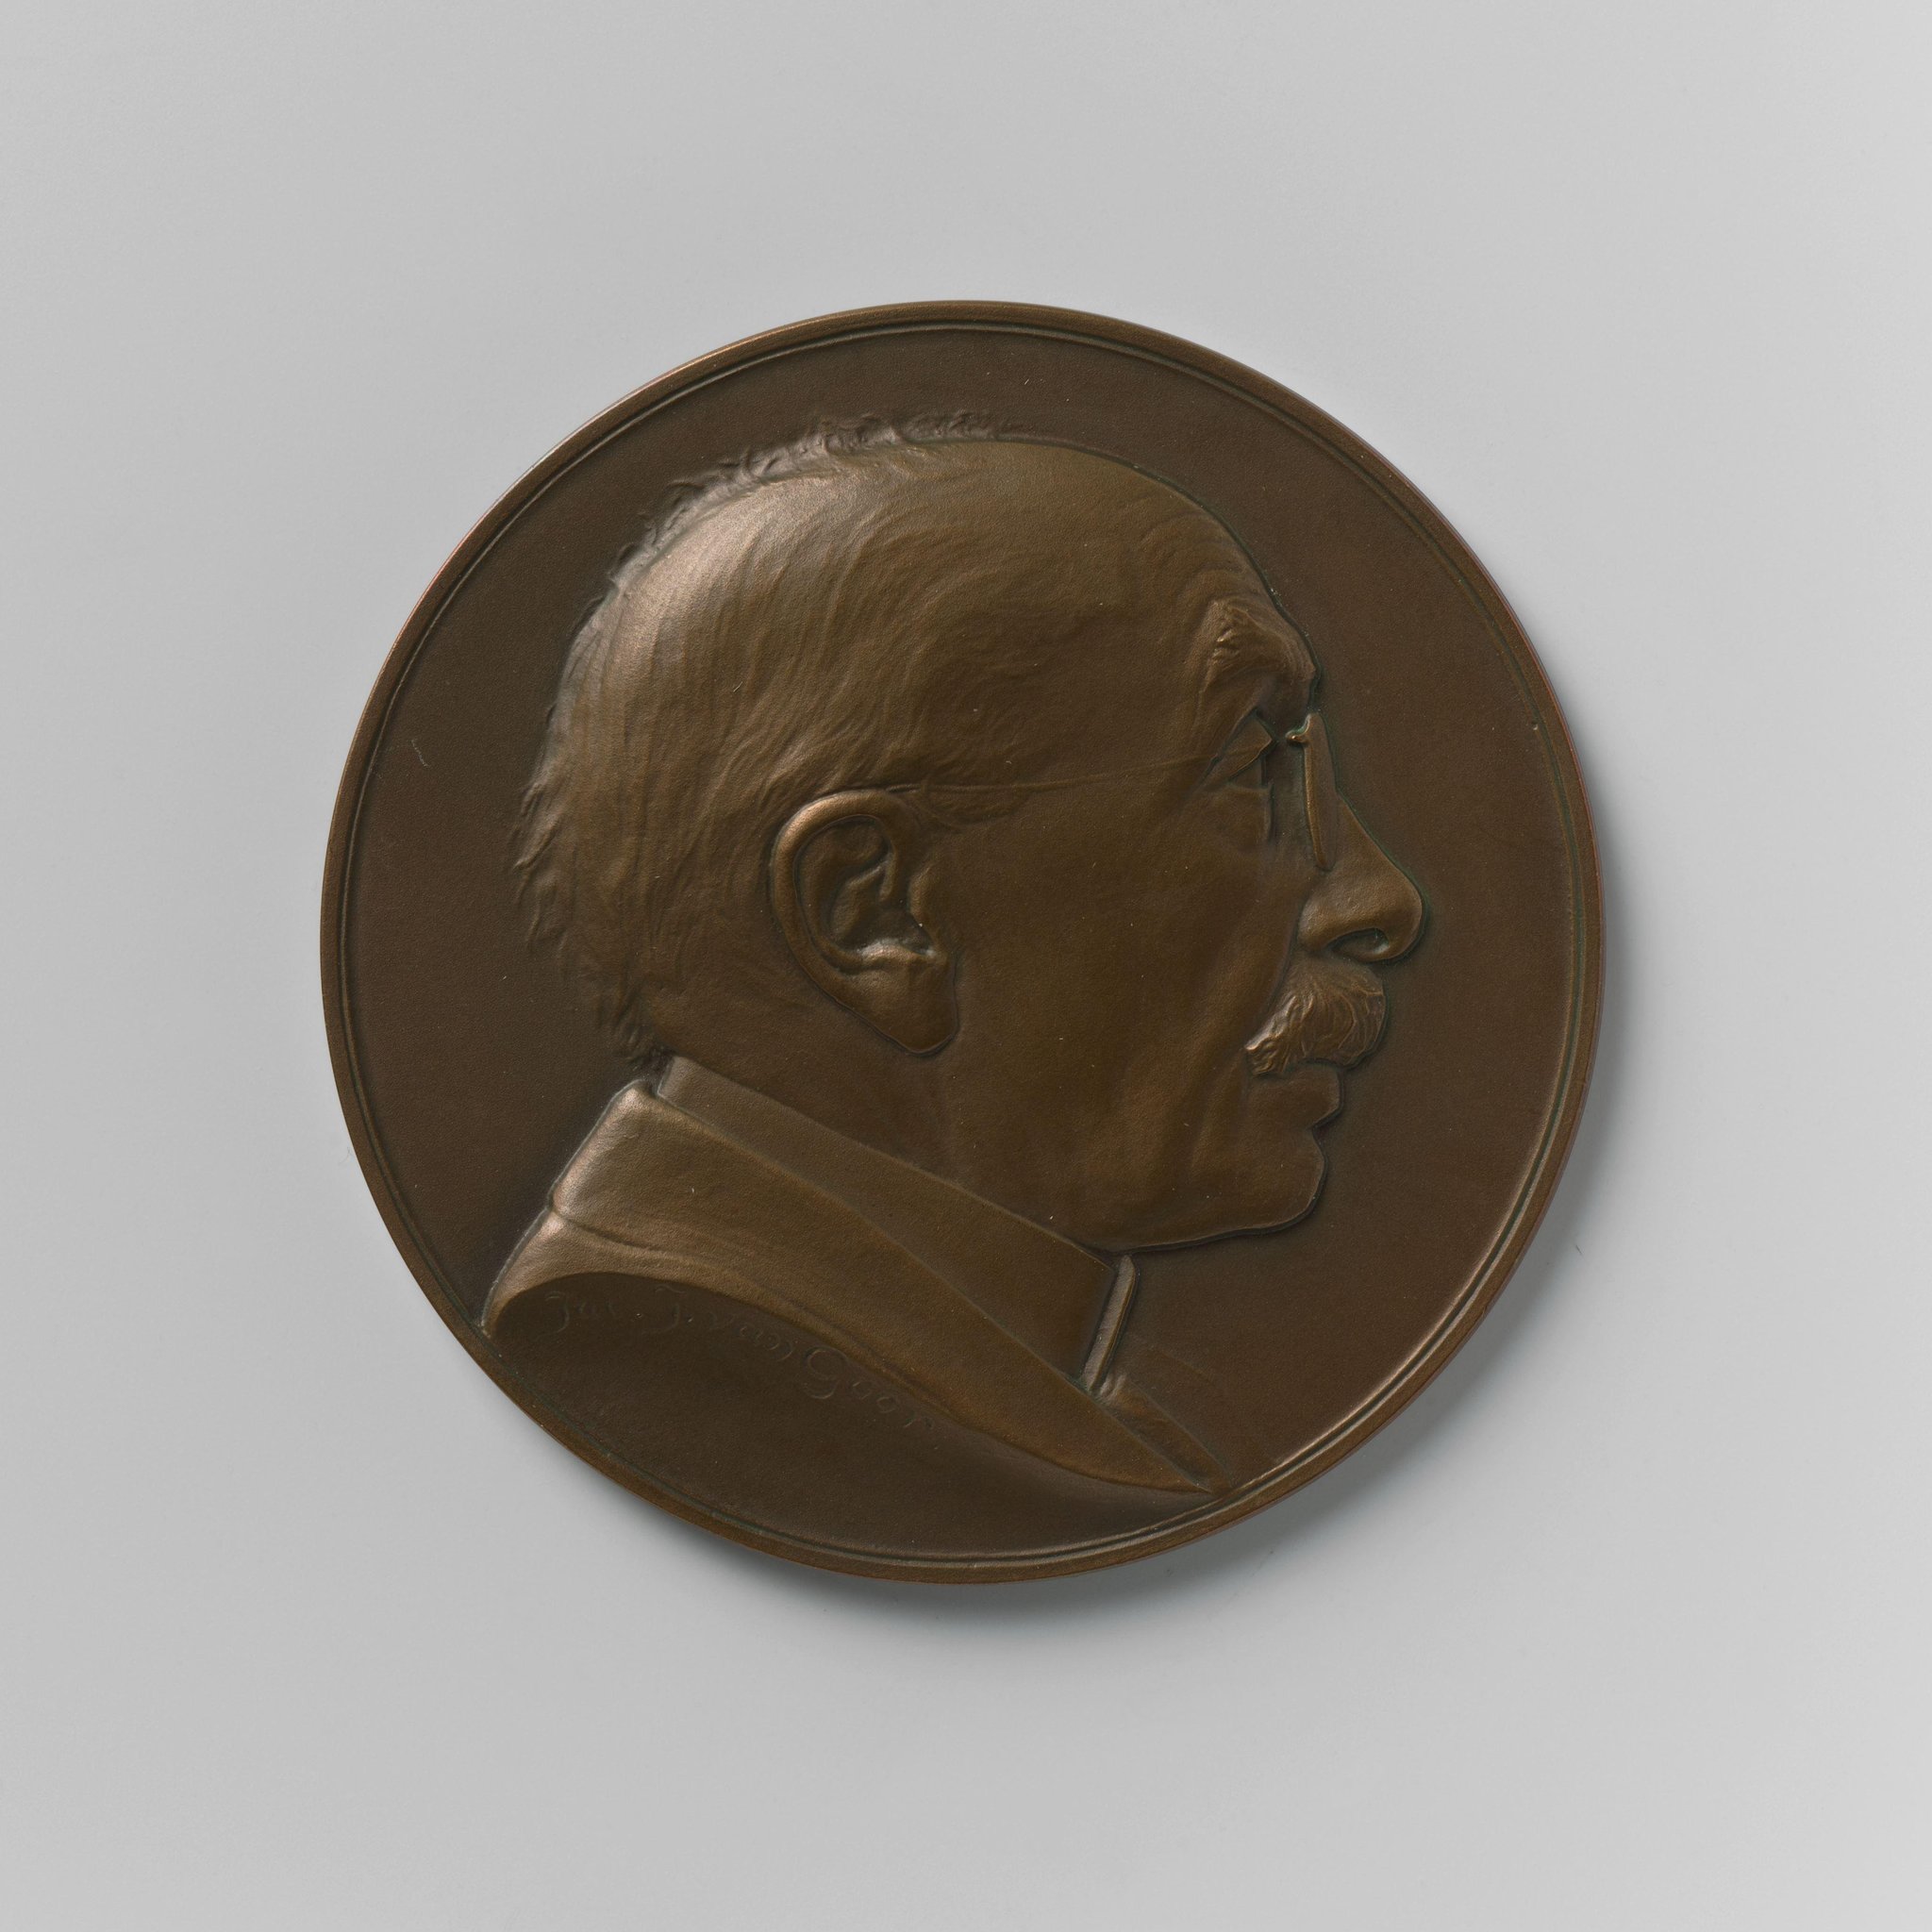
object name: history medal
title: Jacob Böeseken hoogleraar te Delft 1907-1938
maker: jacob jan van goor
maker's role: medailleur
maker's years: 1874-1956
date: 1938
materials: bronze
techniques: striking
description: Bronzen penning, op de voorzijde het borstbeeld van Böeseken naar rechts, op de keerzijde zes regels tekst met enige versiering.